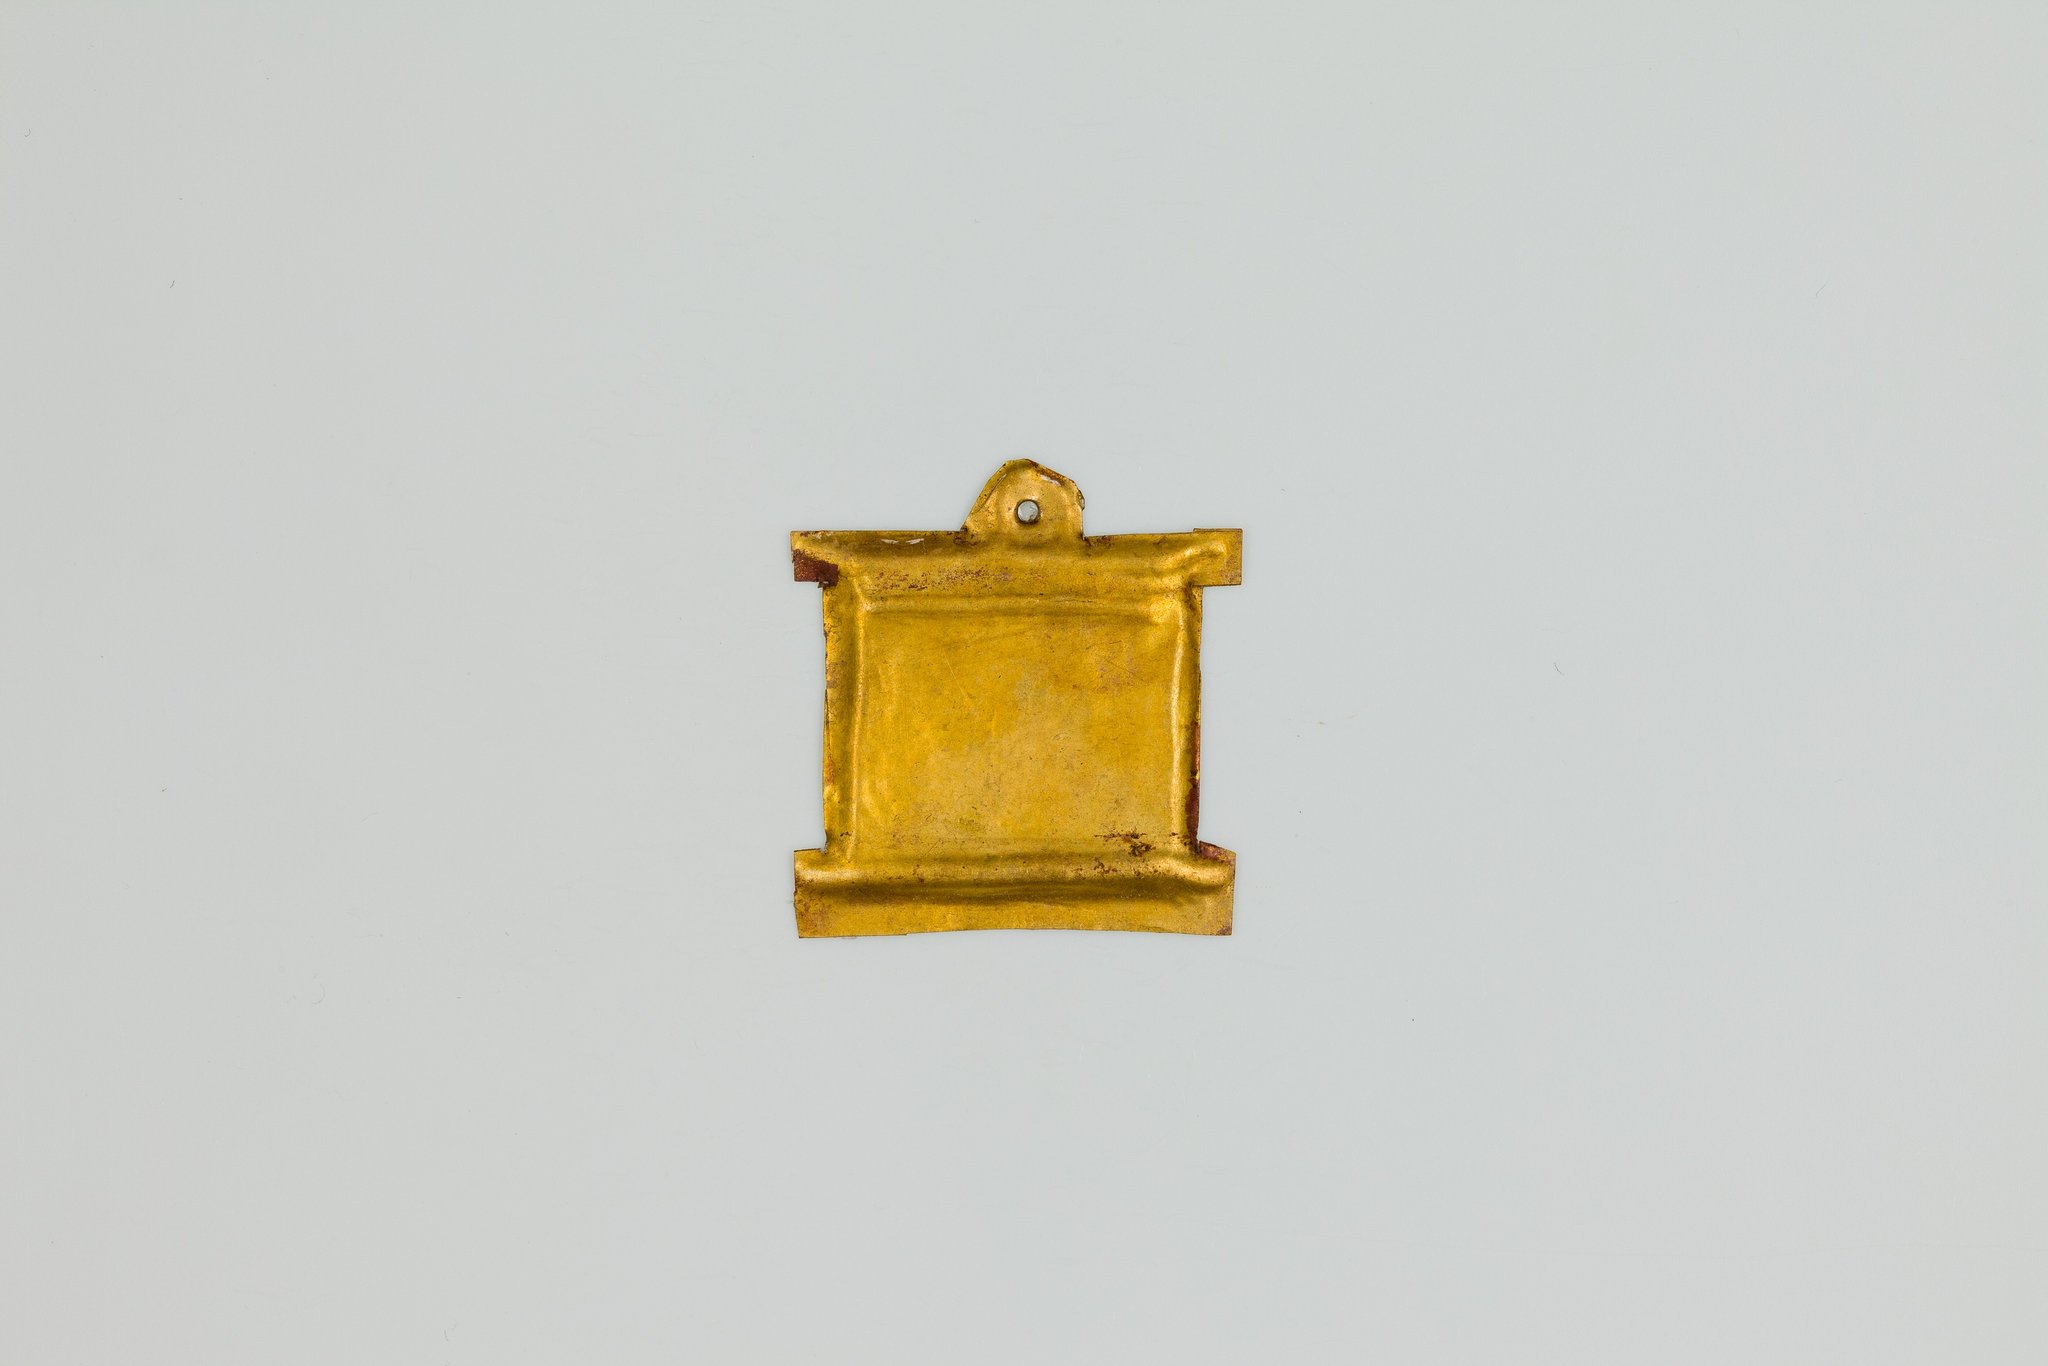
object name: amulet, shrine or pectoral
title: Shrine or pectoral amulet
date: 664-380 BCE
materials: gold